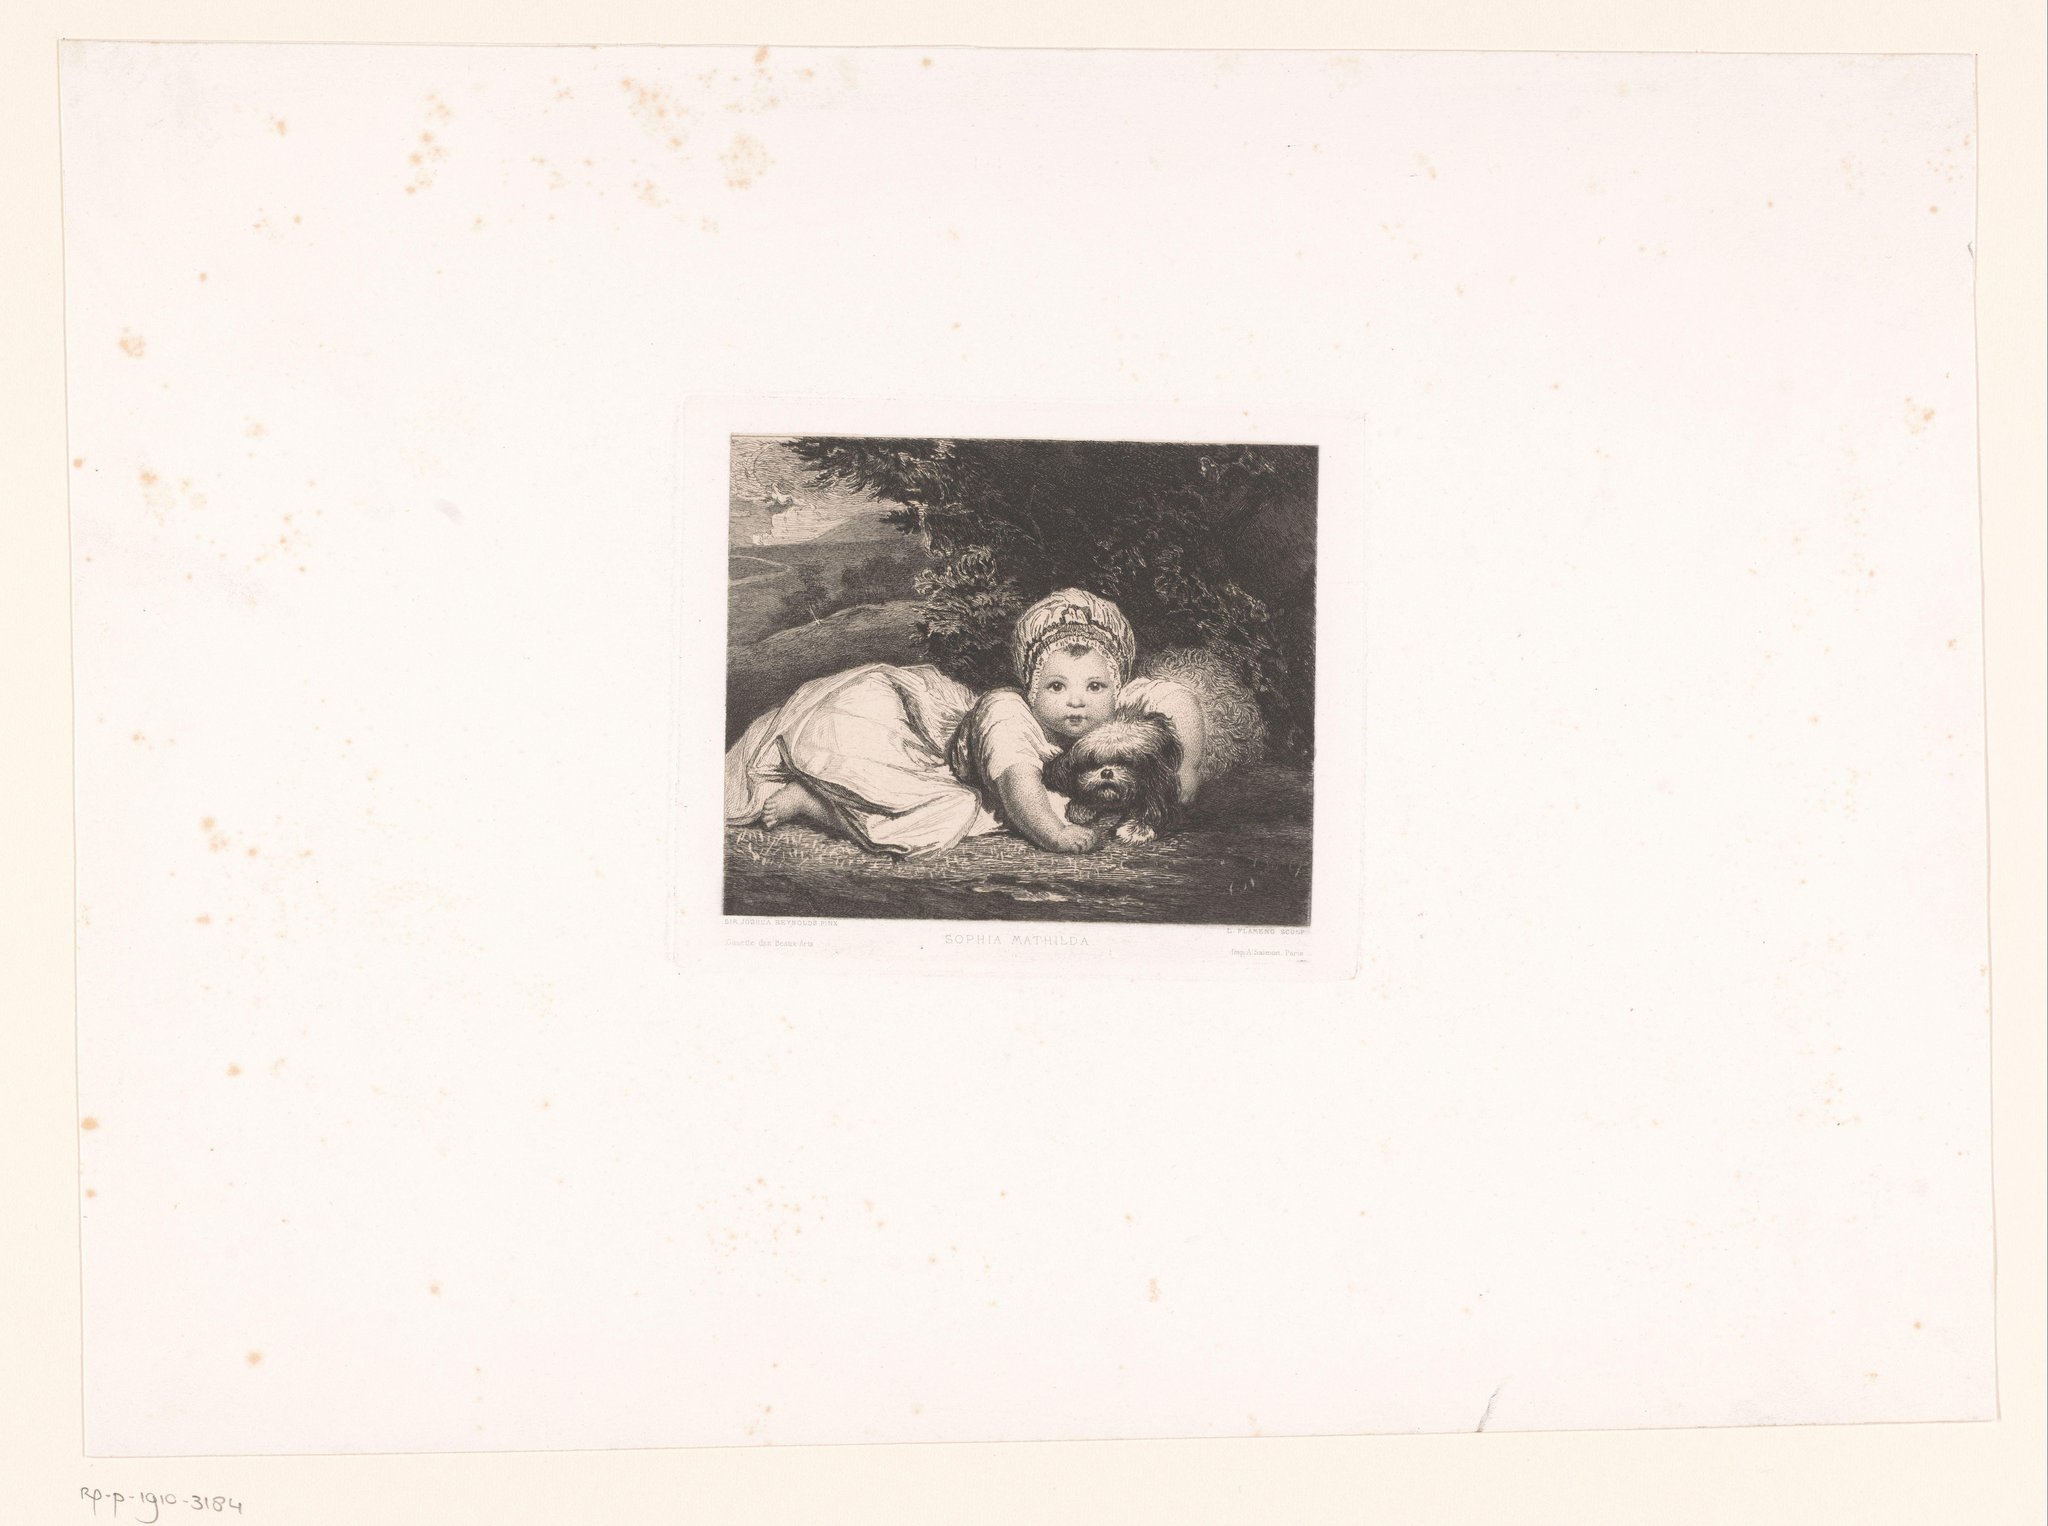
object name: print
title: Prinses Sophia Matilda van Gloucester met haar hondje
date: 1862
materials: paper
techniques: etching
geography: paris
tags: london, princess, toddler - aa - girl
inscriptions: collector's mark: Lugt 2228